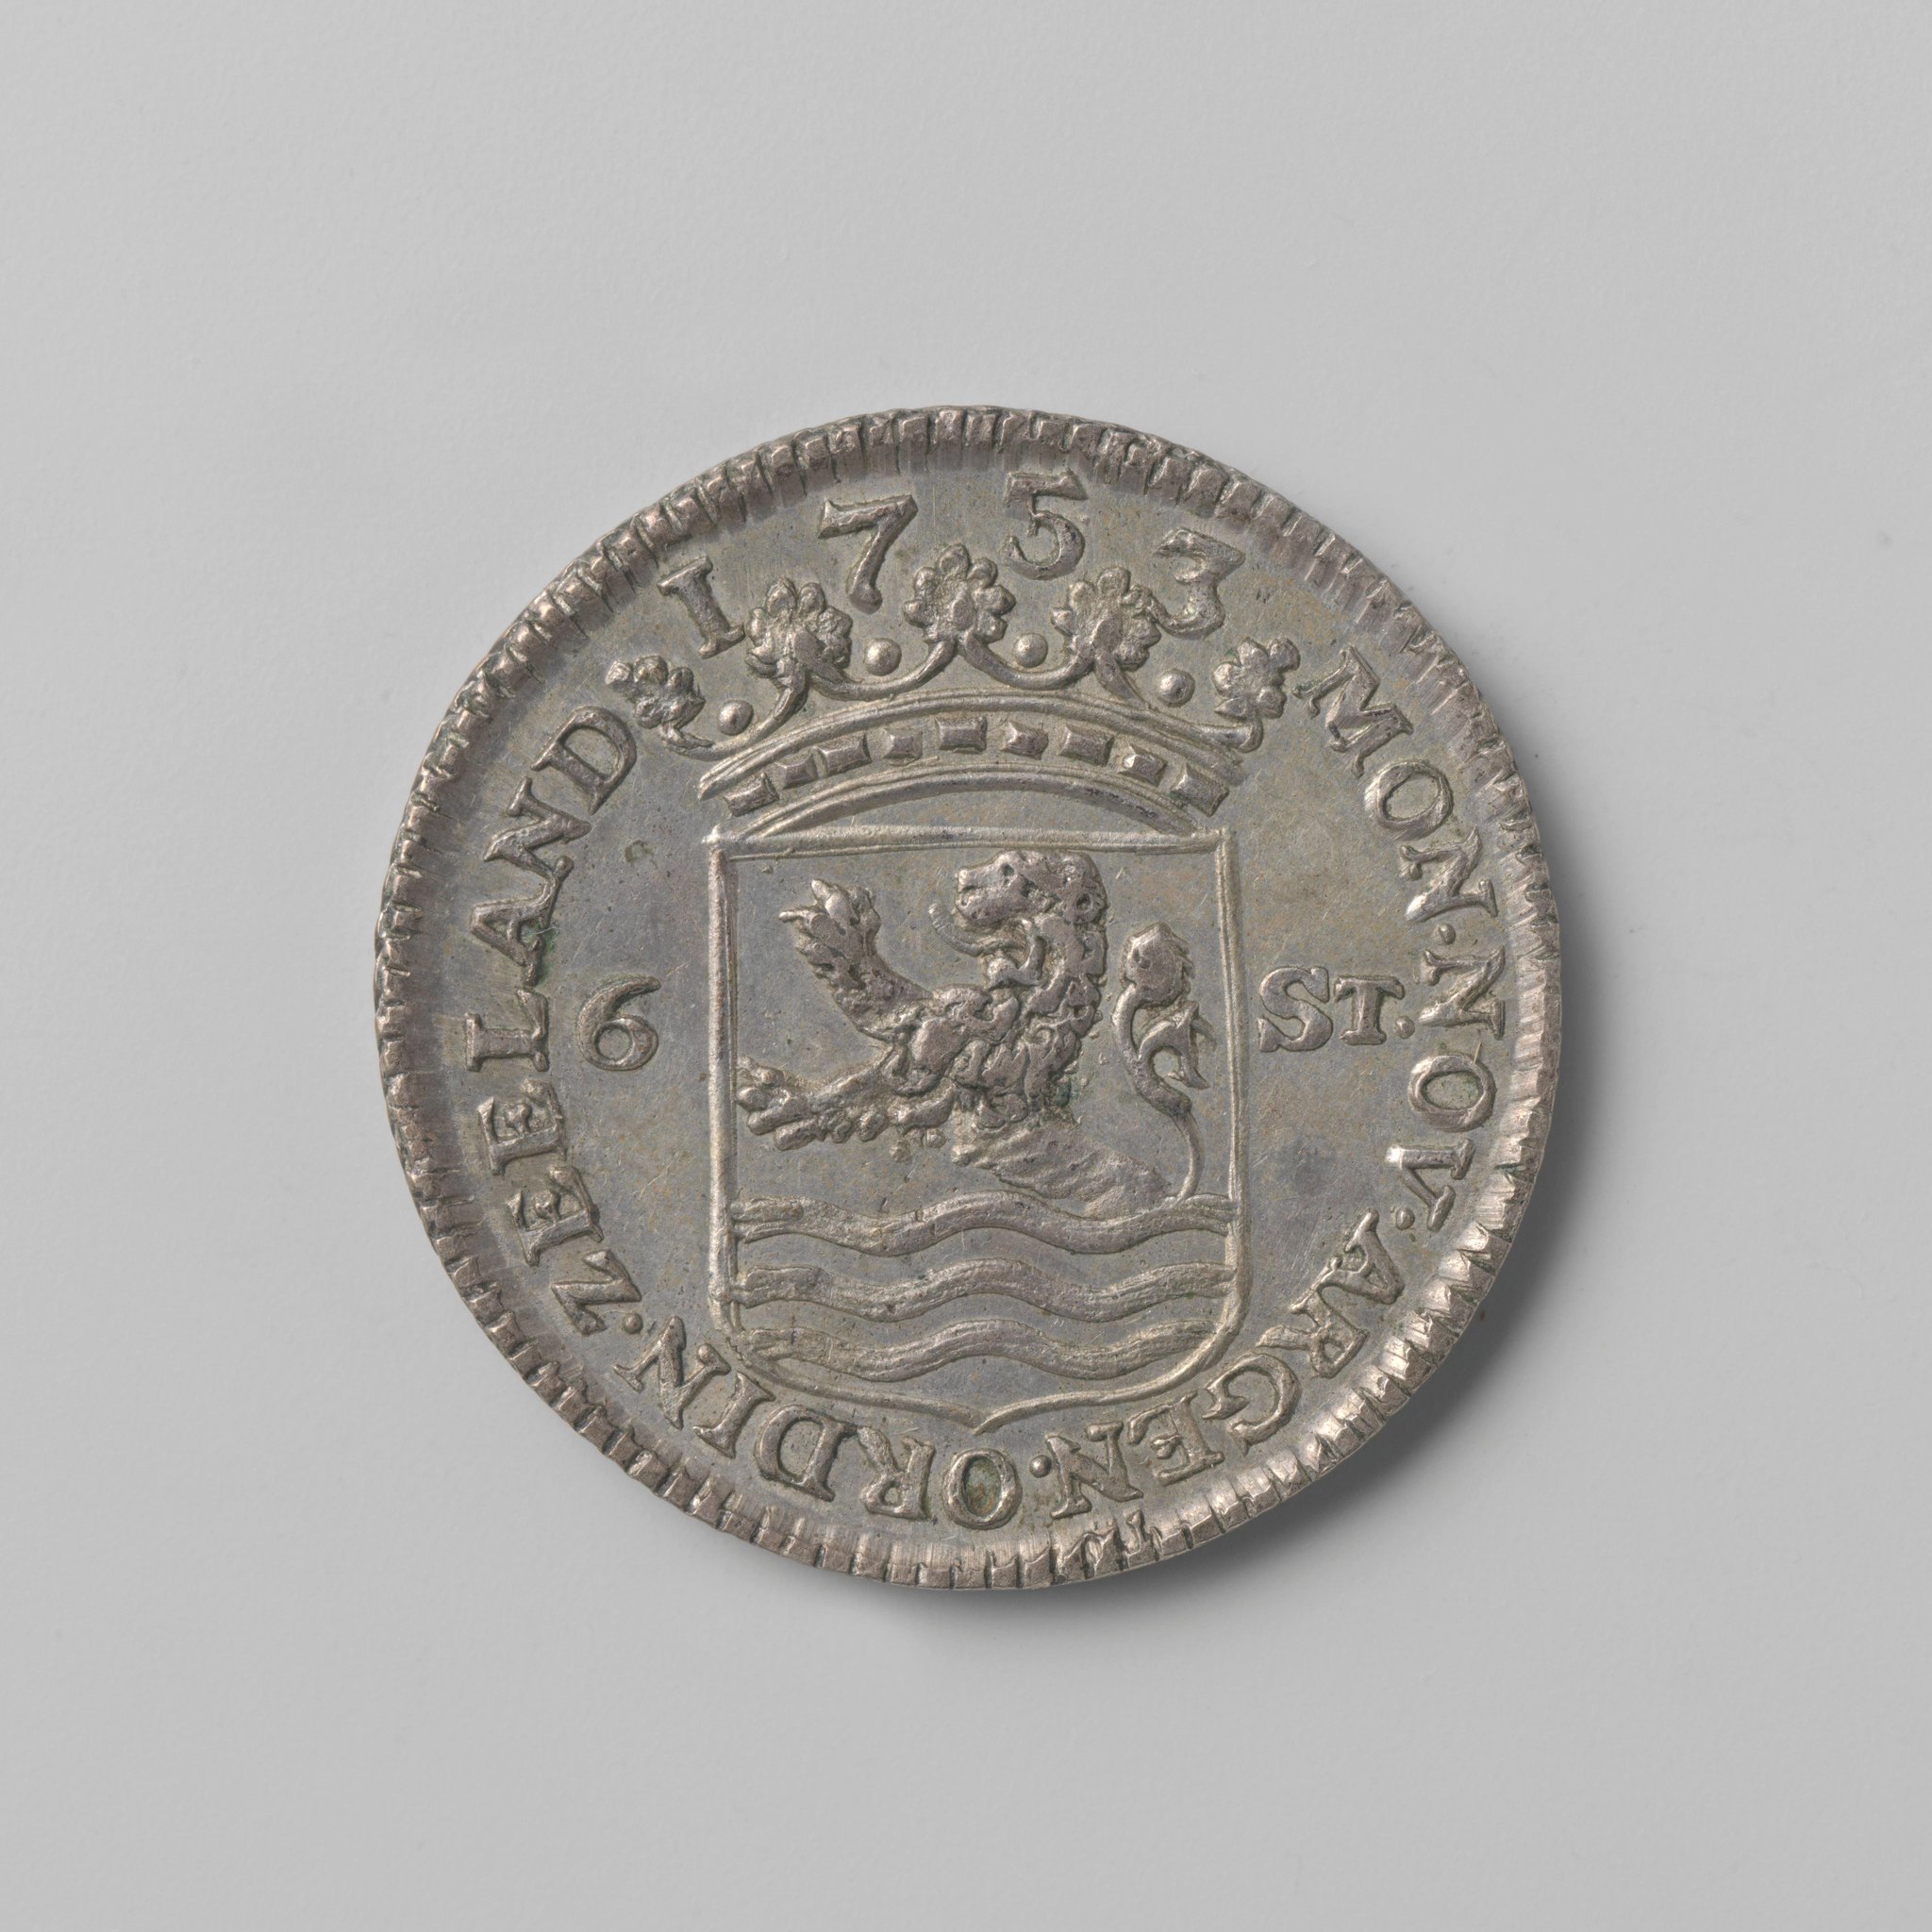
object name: coin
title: Zeeland, scheepjesschelling, 1753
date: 1753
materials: silver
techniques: striking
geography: middelburg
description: Zilveren munt. Voorzijde: tussen waarde-aanduiding 6 ST gekroond wapenschild van Zeeland. Boven kroon jaartal. Keerzijde: oorlogsschip varend naar rechts, op achtersteven Nederlandse vlag. Kabelrand. Piedfort.